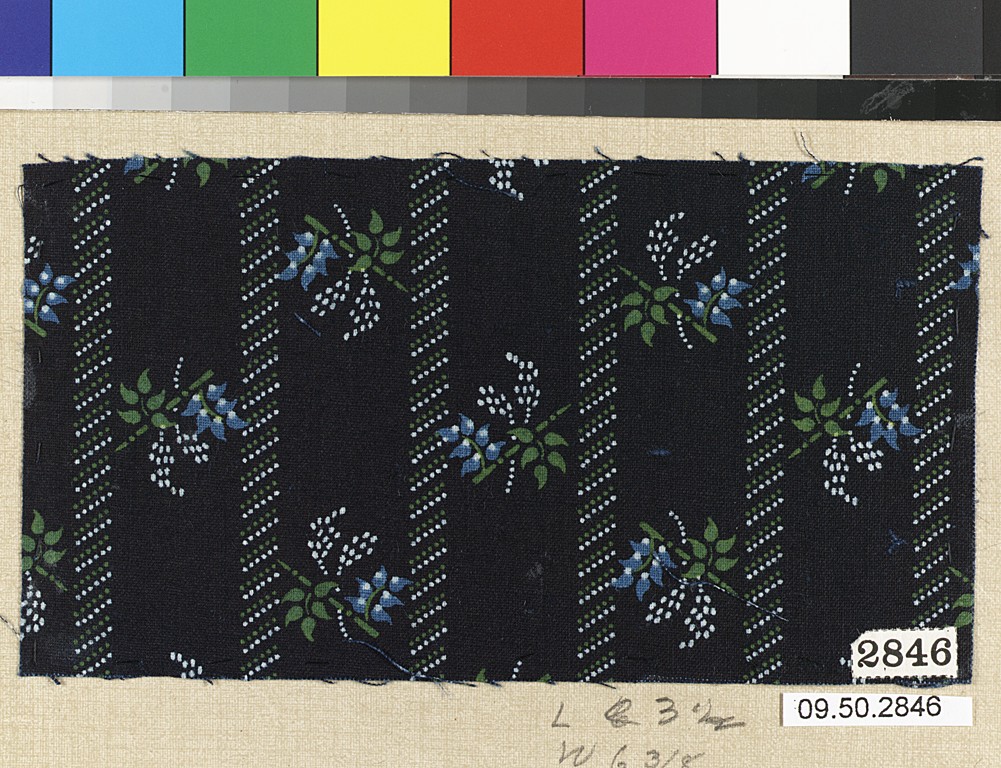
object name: piece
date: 1801-1900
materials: cotton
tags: flowers,leaves